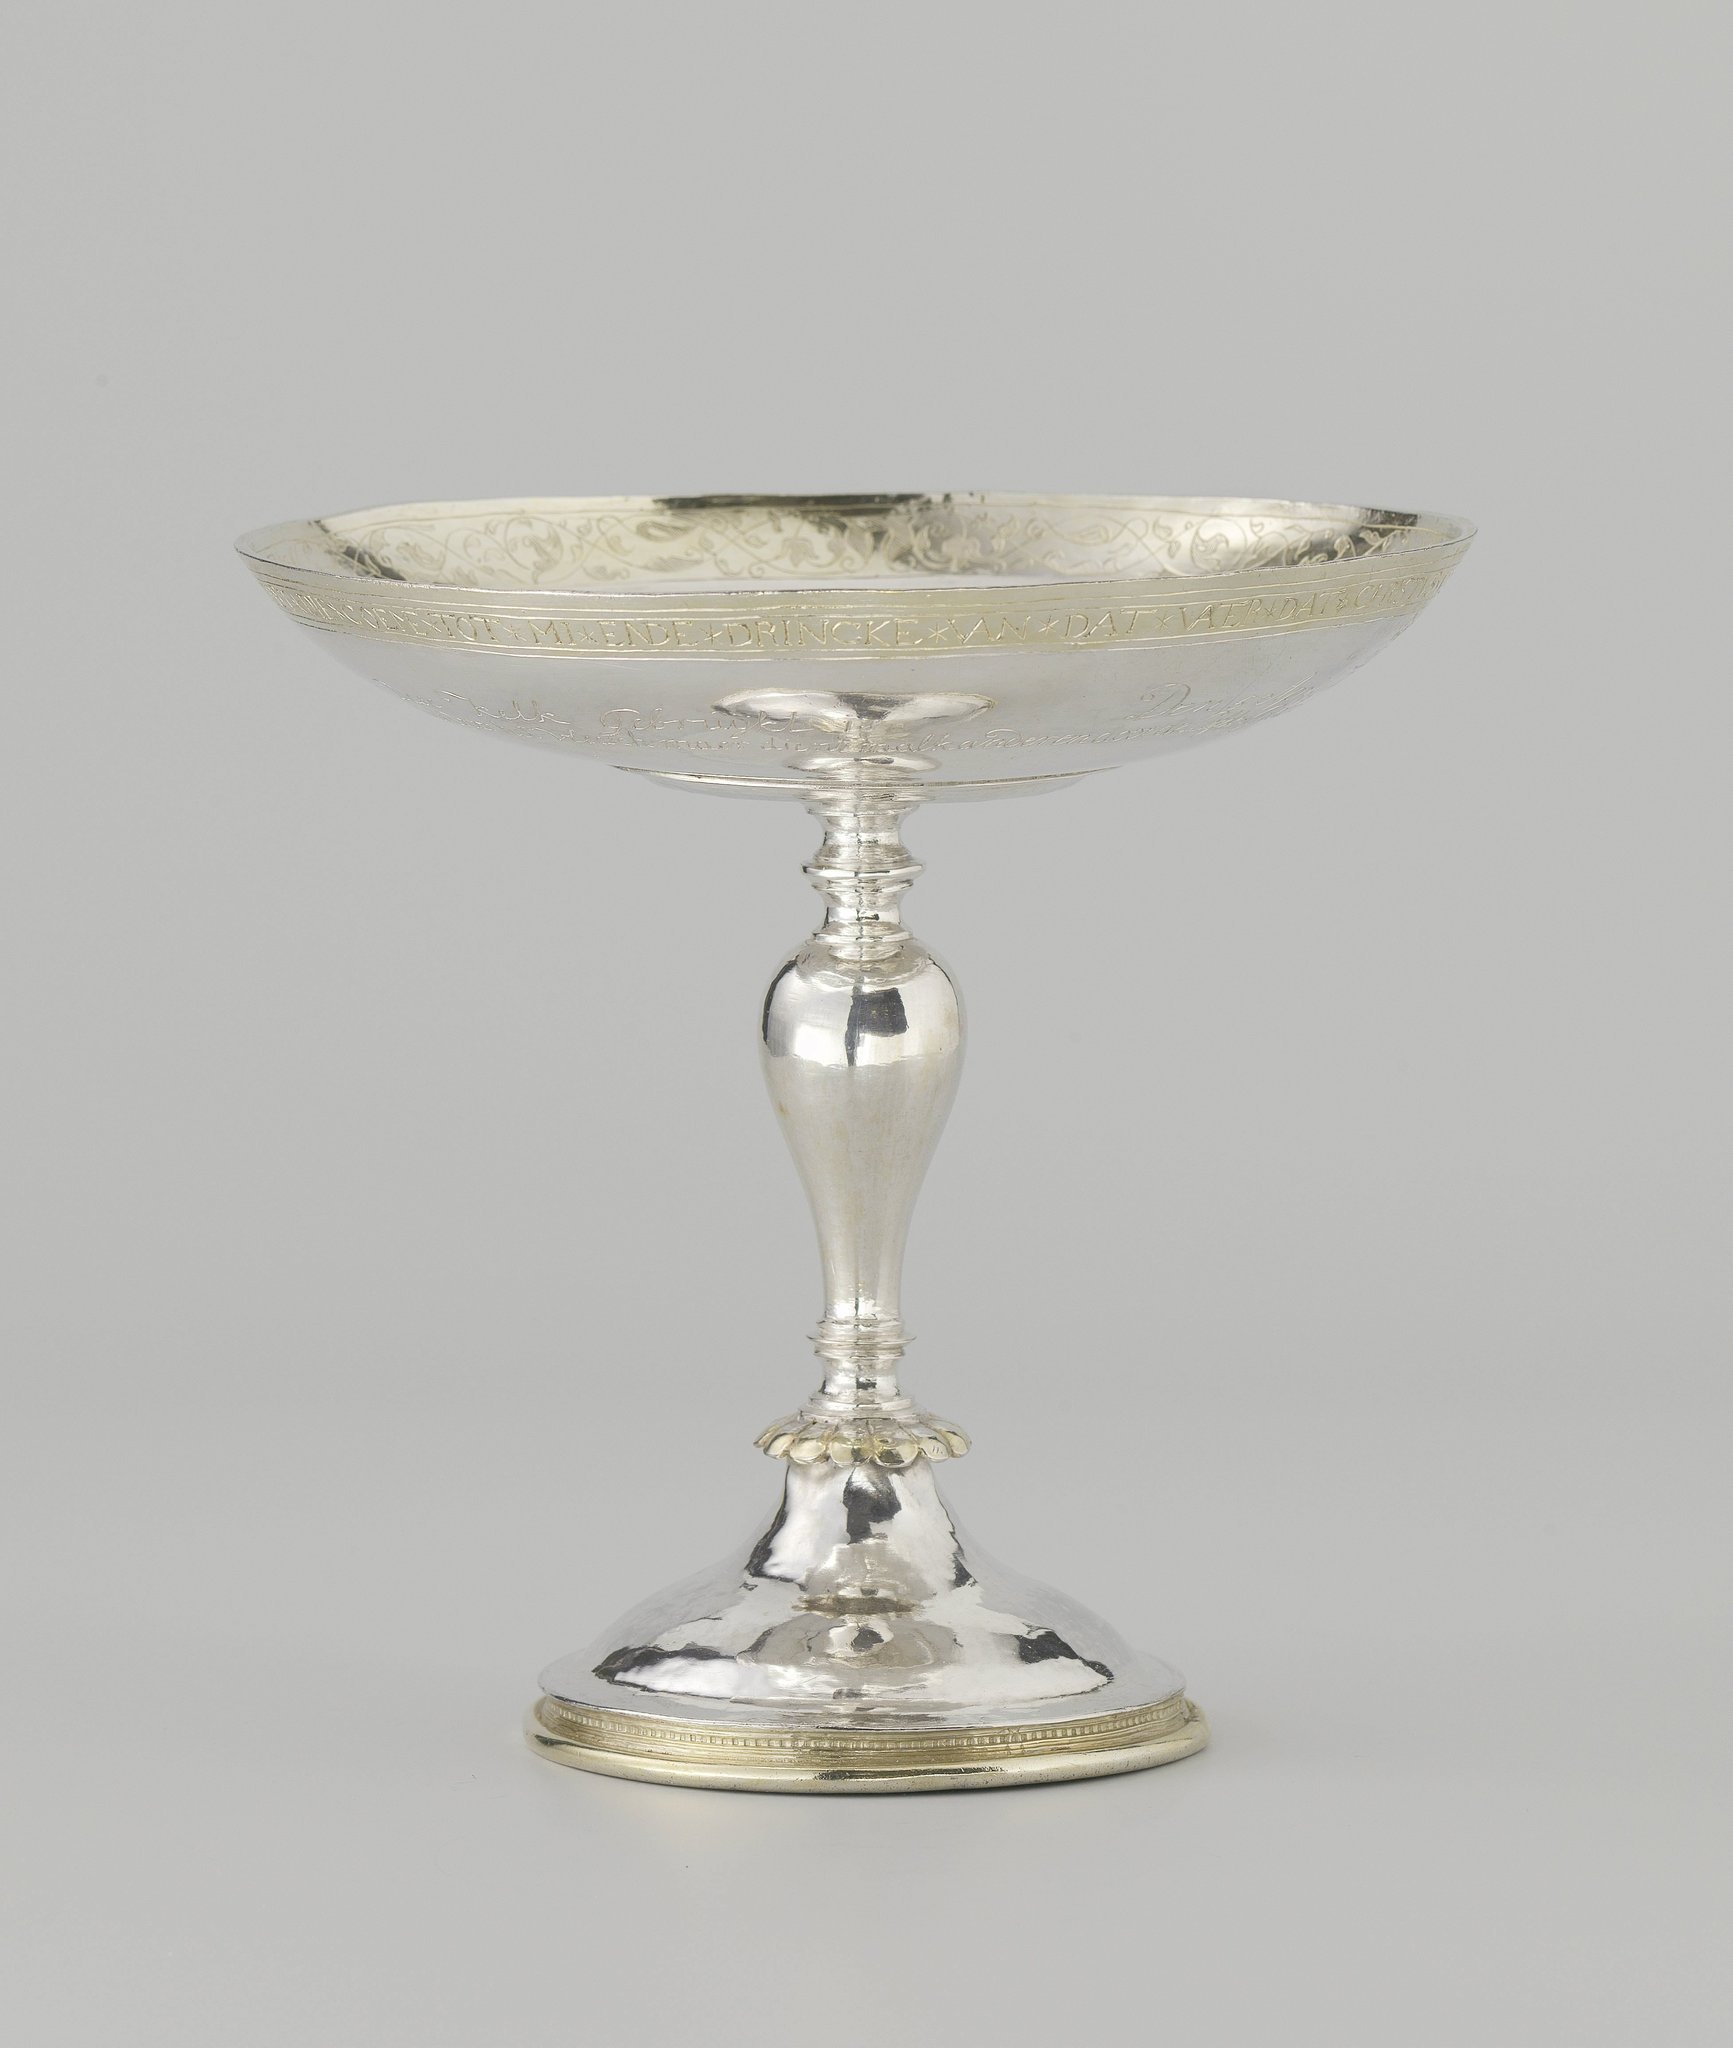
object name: tazza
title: Drinking cup with a portrait of Emperor Charles V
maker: Anonymous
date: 1565-1566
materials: silver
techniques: gilding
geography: antwerp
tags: ghent, charles v (holy roman emperor and king of spain), flushing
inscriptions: date letter: ‘G’, maker's mark, signature: ‘IG’, mark: ‘Vlissingen’, inscription: ‘CHRISTUS DIE SPREGHT VIE DAER DORST DIE COEME TOT MI ENDE DRINCKE VAN DAT VATER DAT CHRISTUS V GEFT DIE EN SAL INDER EVICHEIT NIET MER DORSTEN IOAN 7 Den 5 April 1571/1772 door Dom Justus Tjeenk Gepredikt in de Engelsche Kerk te Vlissingen alwaer Dese Kelk Gebruijkt is. Want gij Zijt tot vrijhijt geroepen Broeders en alleen lijden en gebruijkt de vrijheit niet tot een oorsake voor het vleesch: maer dient malkander door de Liefde Gelaten 5V13’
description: Whether an object is ‘religious’ or ‘secular’ in nature depends on its function. In the case of this cup, both apply. It bears a portrait of Holy Roman Emperor Charles V, indicating that it originally was intended as a secular object. However, the inscription records that it served as a communion cup at the first Protestant service held in the Dutch town of Vlissingen in 1572.